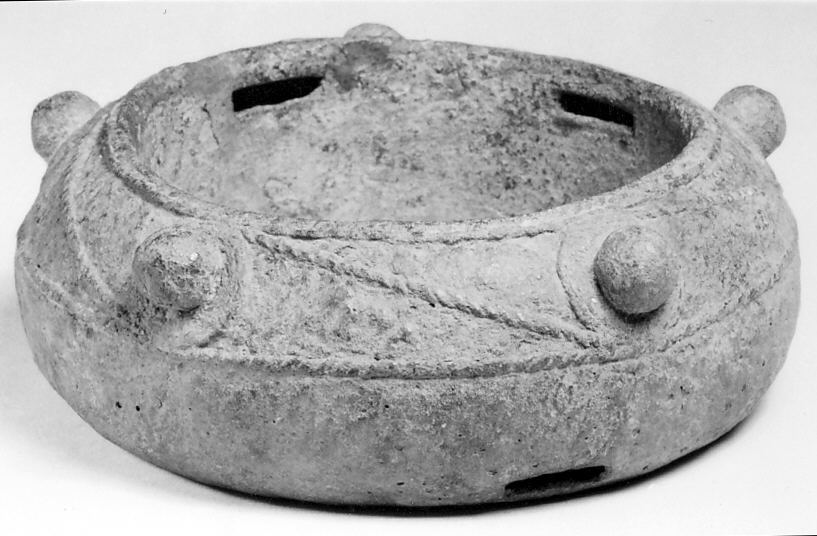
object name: hair ornament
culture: thai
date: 300 BCE-200 CE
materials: bronze